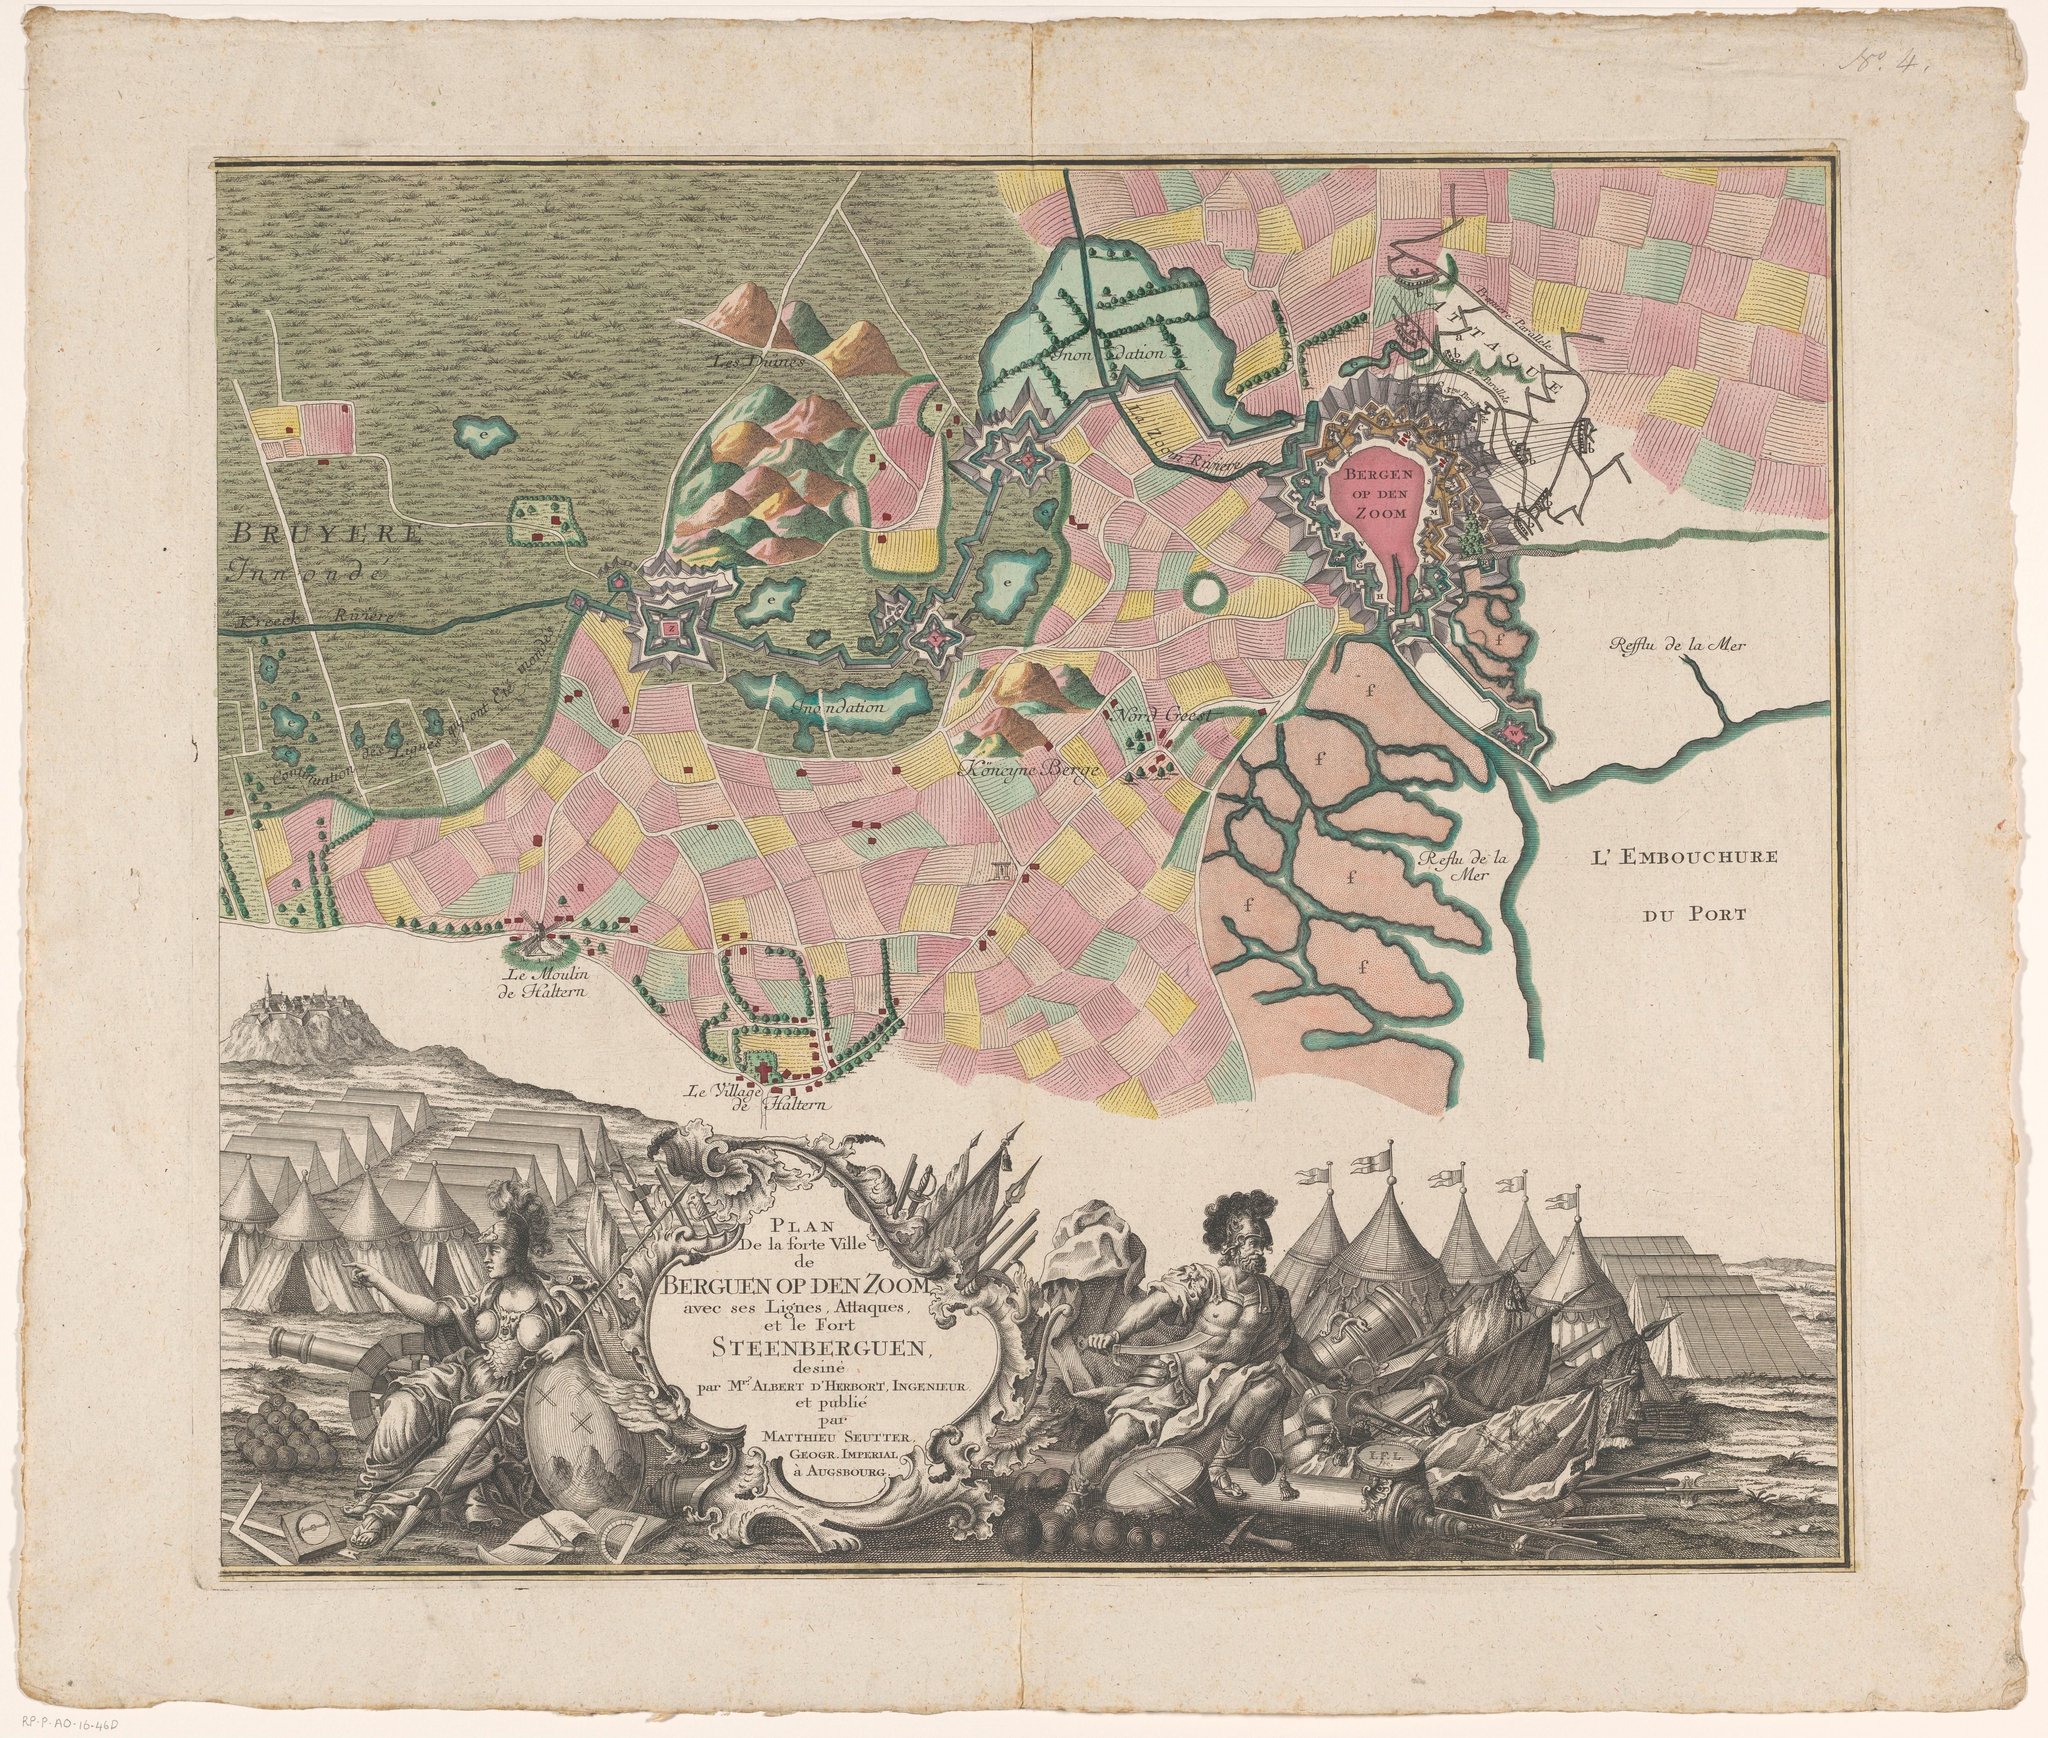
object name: map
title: Plan de la forte ville de Berguen op den Zoom, avec ses lignes, attaques et le Fort Steenberguen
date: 1747-1757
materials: paper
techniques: engraving, etching, hand coloring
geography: augsburg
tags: (story of) mars (ares), maps of separate countries or regions, (story of) minerva (pallas, athena), weapons, tent-camp, bergen op zoom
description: Rechterdeel van een kaart van het Beleg van Bergen op Zoom in 1747, bestaande uit twee delen.